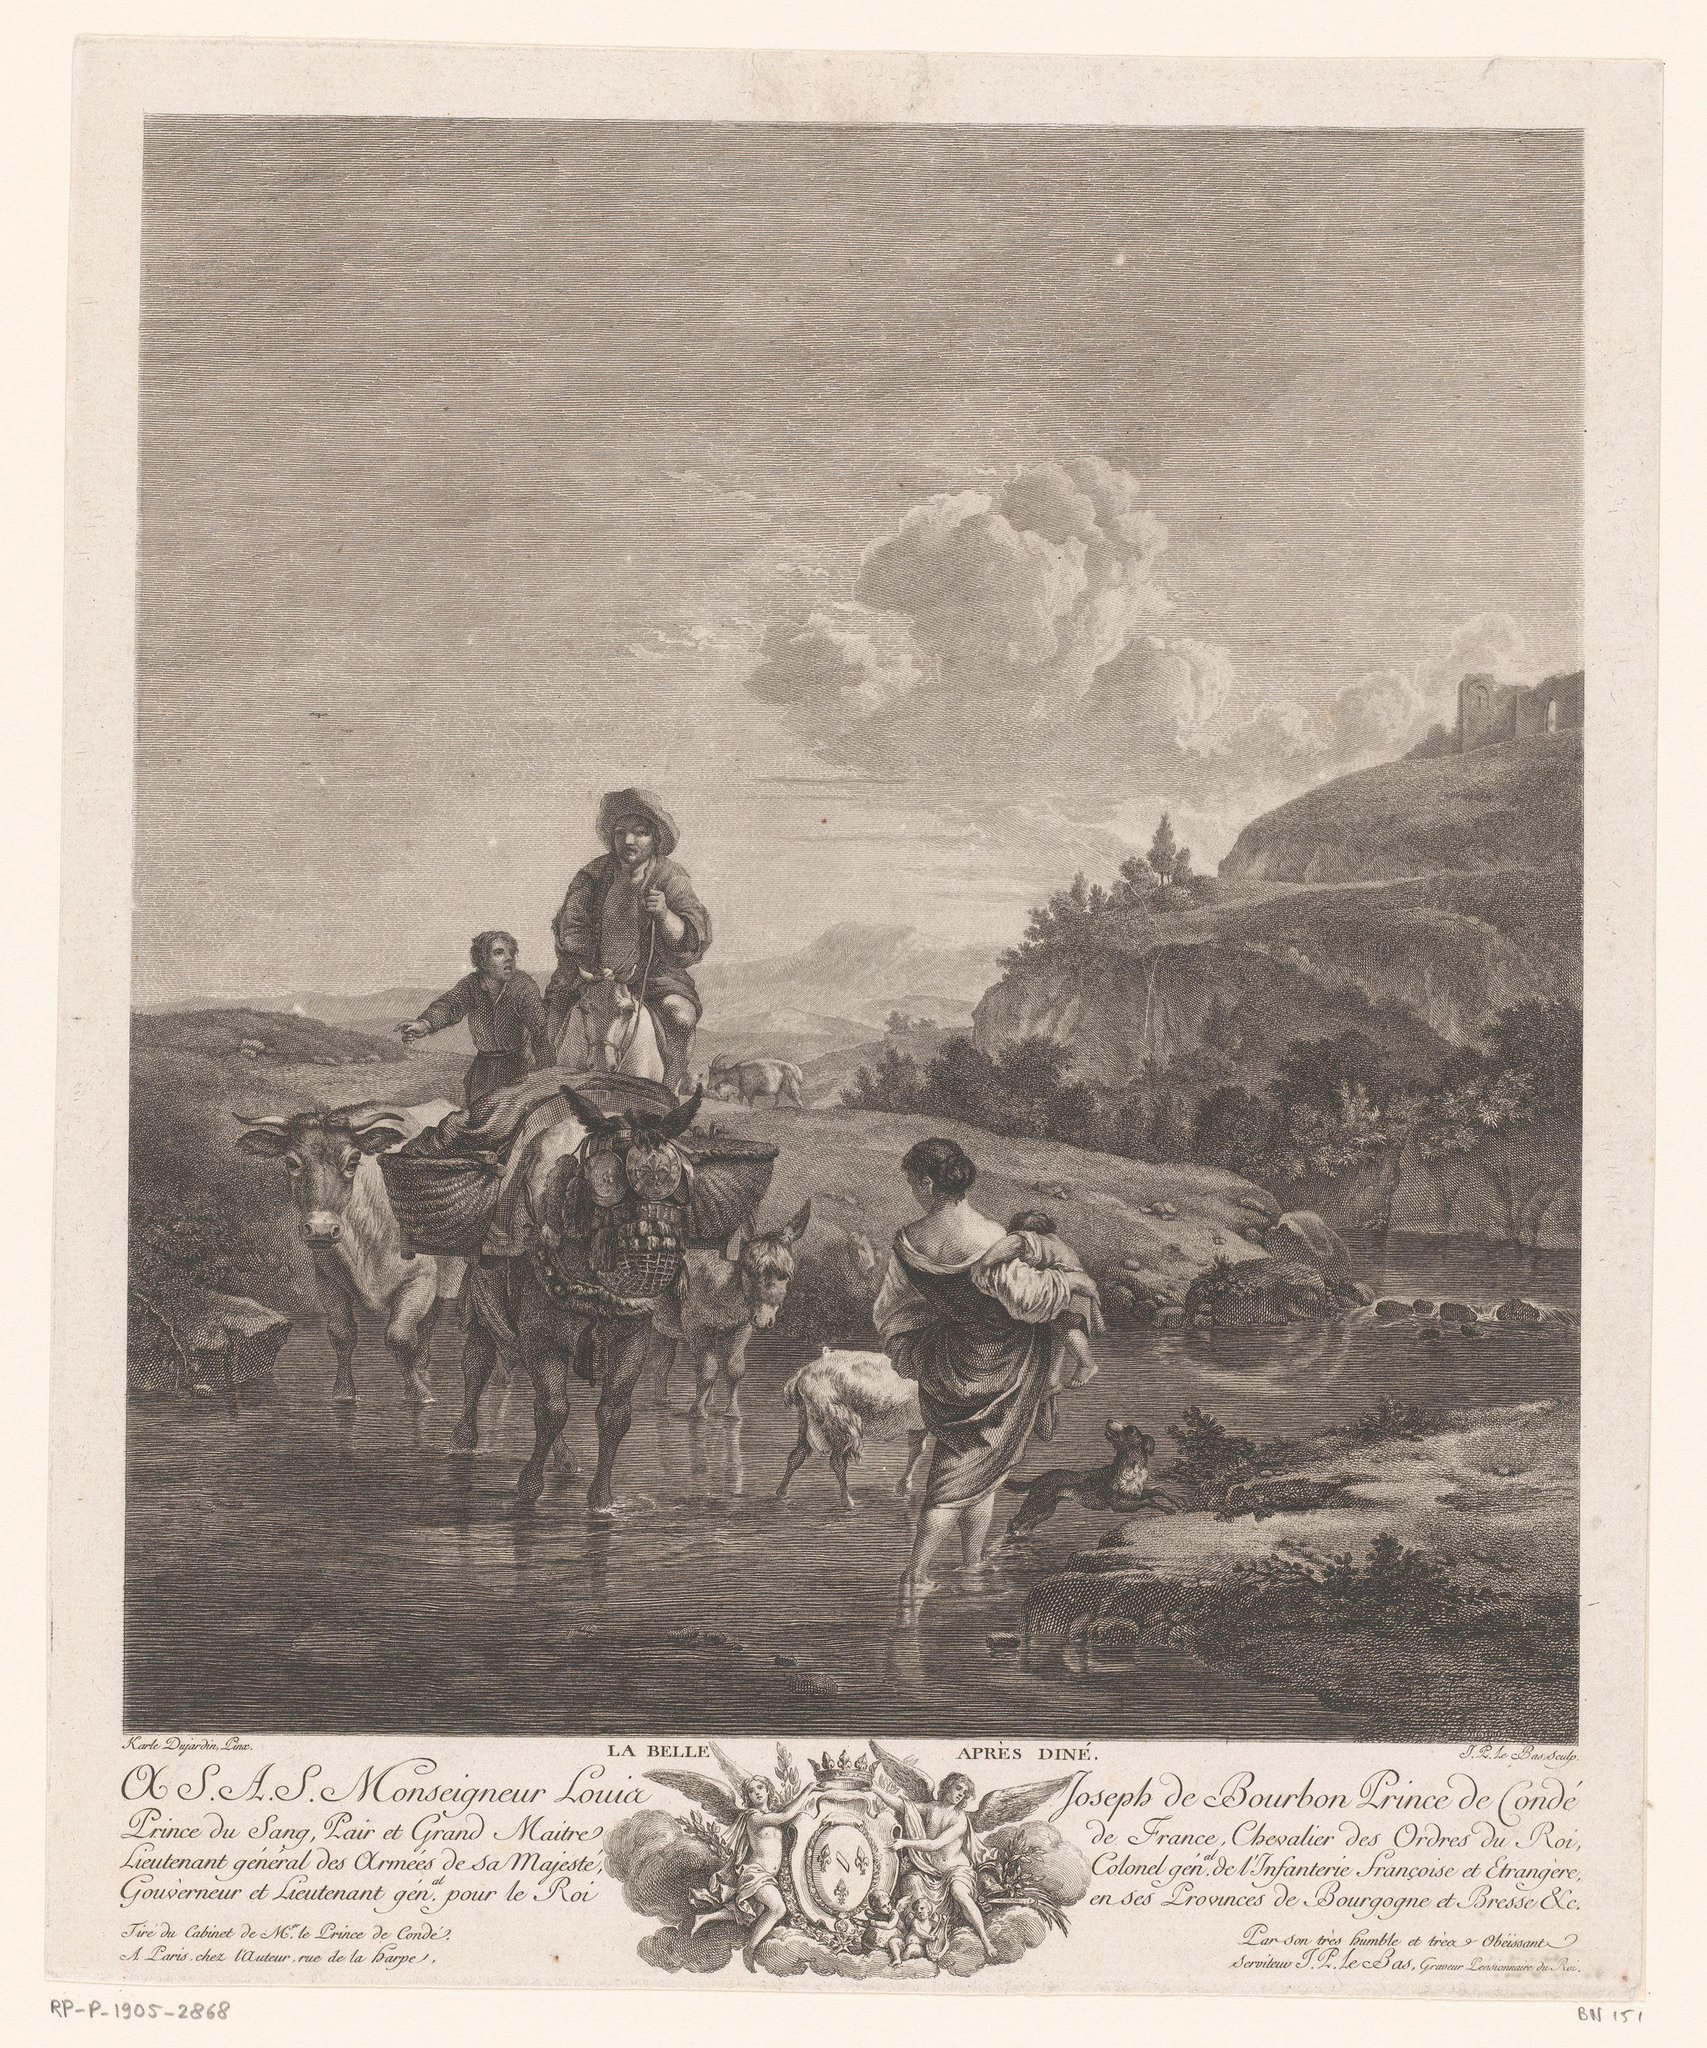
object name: print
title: Landschap met herders bij een doorwaadbare plaats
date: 1781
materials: paper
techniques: engraving, etching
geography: paris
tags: herding, herdsman, herdswoman, shepherd, shepherdess, cowherd, etc., ford, landscapes (+ landscape with figures, staffage)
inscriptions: collector's mark: Lugt 2228, number: ‘N. 762.’